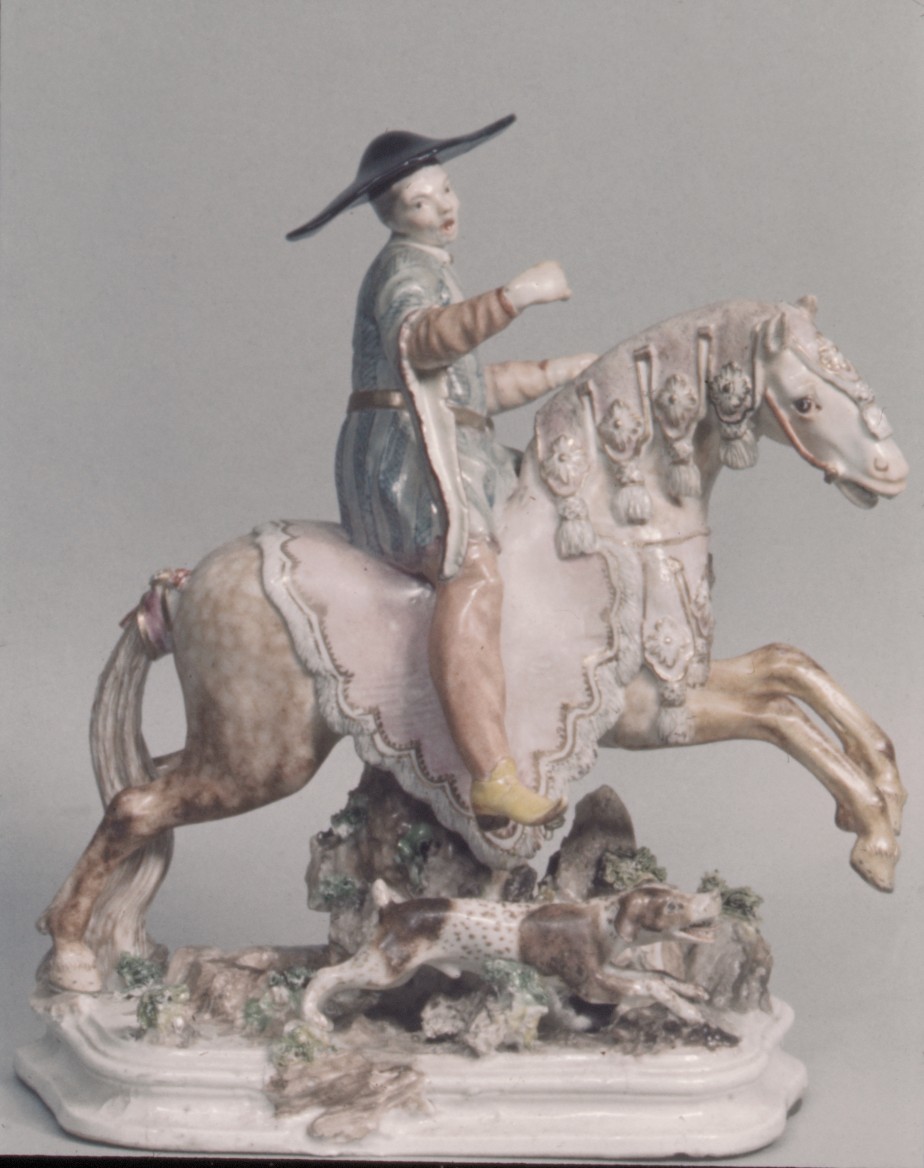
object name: group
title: Chinese horseman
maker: nymphenburg porcelain manufactory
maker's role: manufactory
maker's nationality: german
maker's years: 1747-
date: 1765-1770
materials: hard paste porcelain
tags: men,dogs,horses